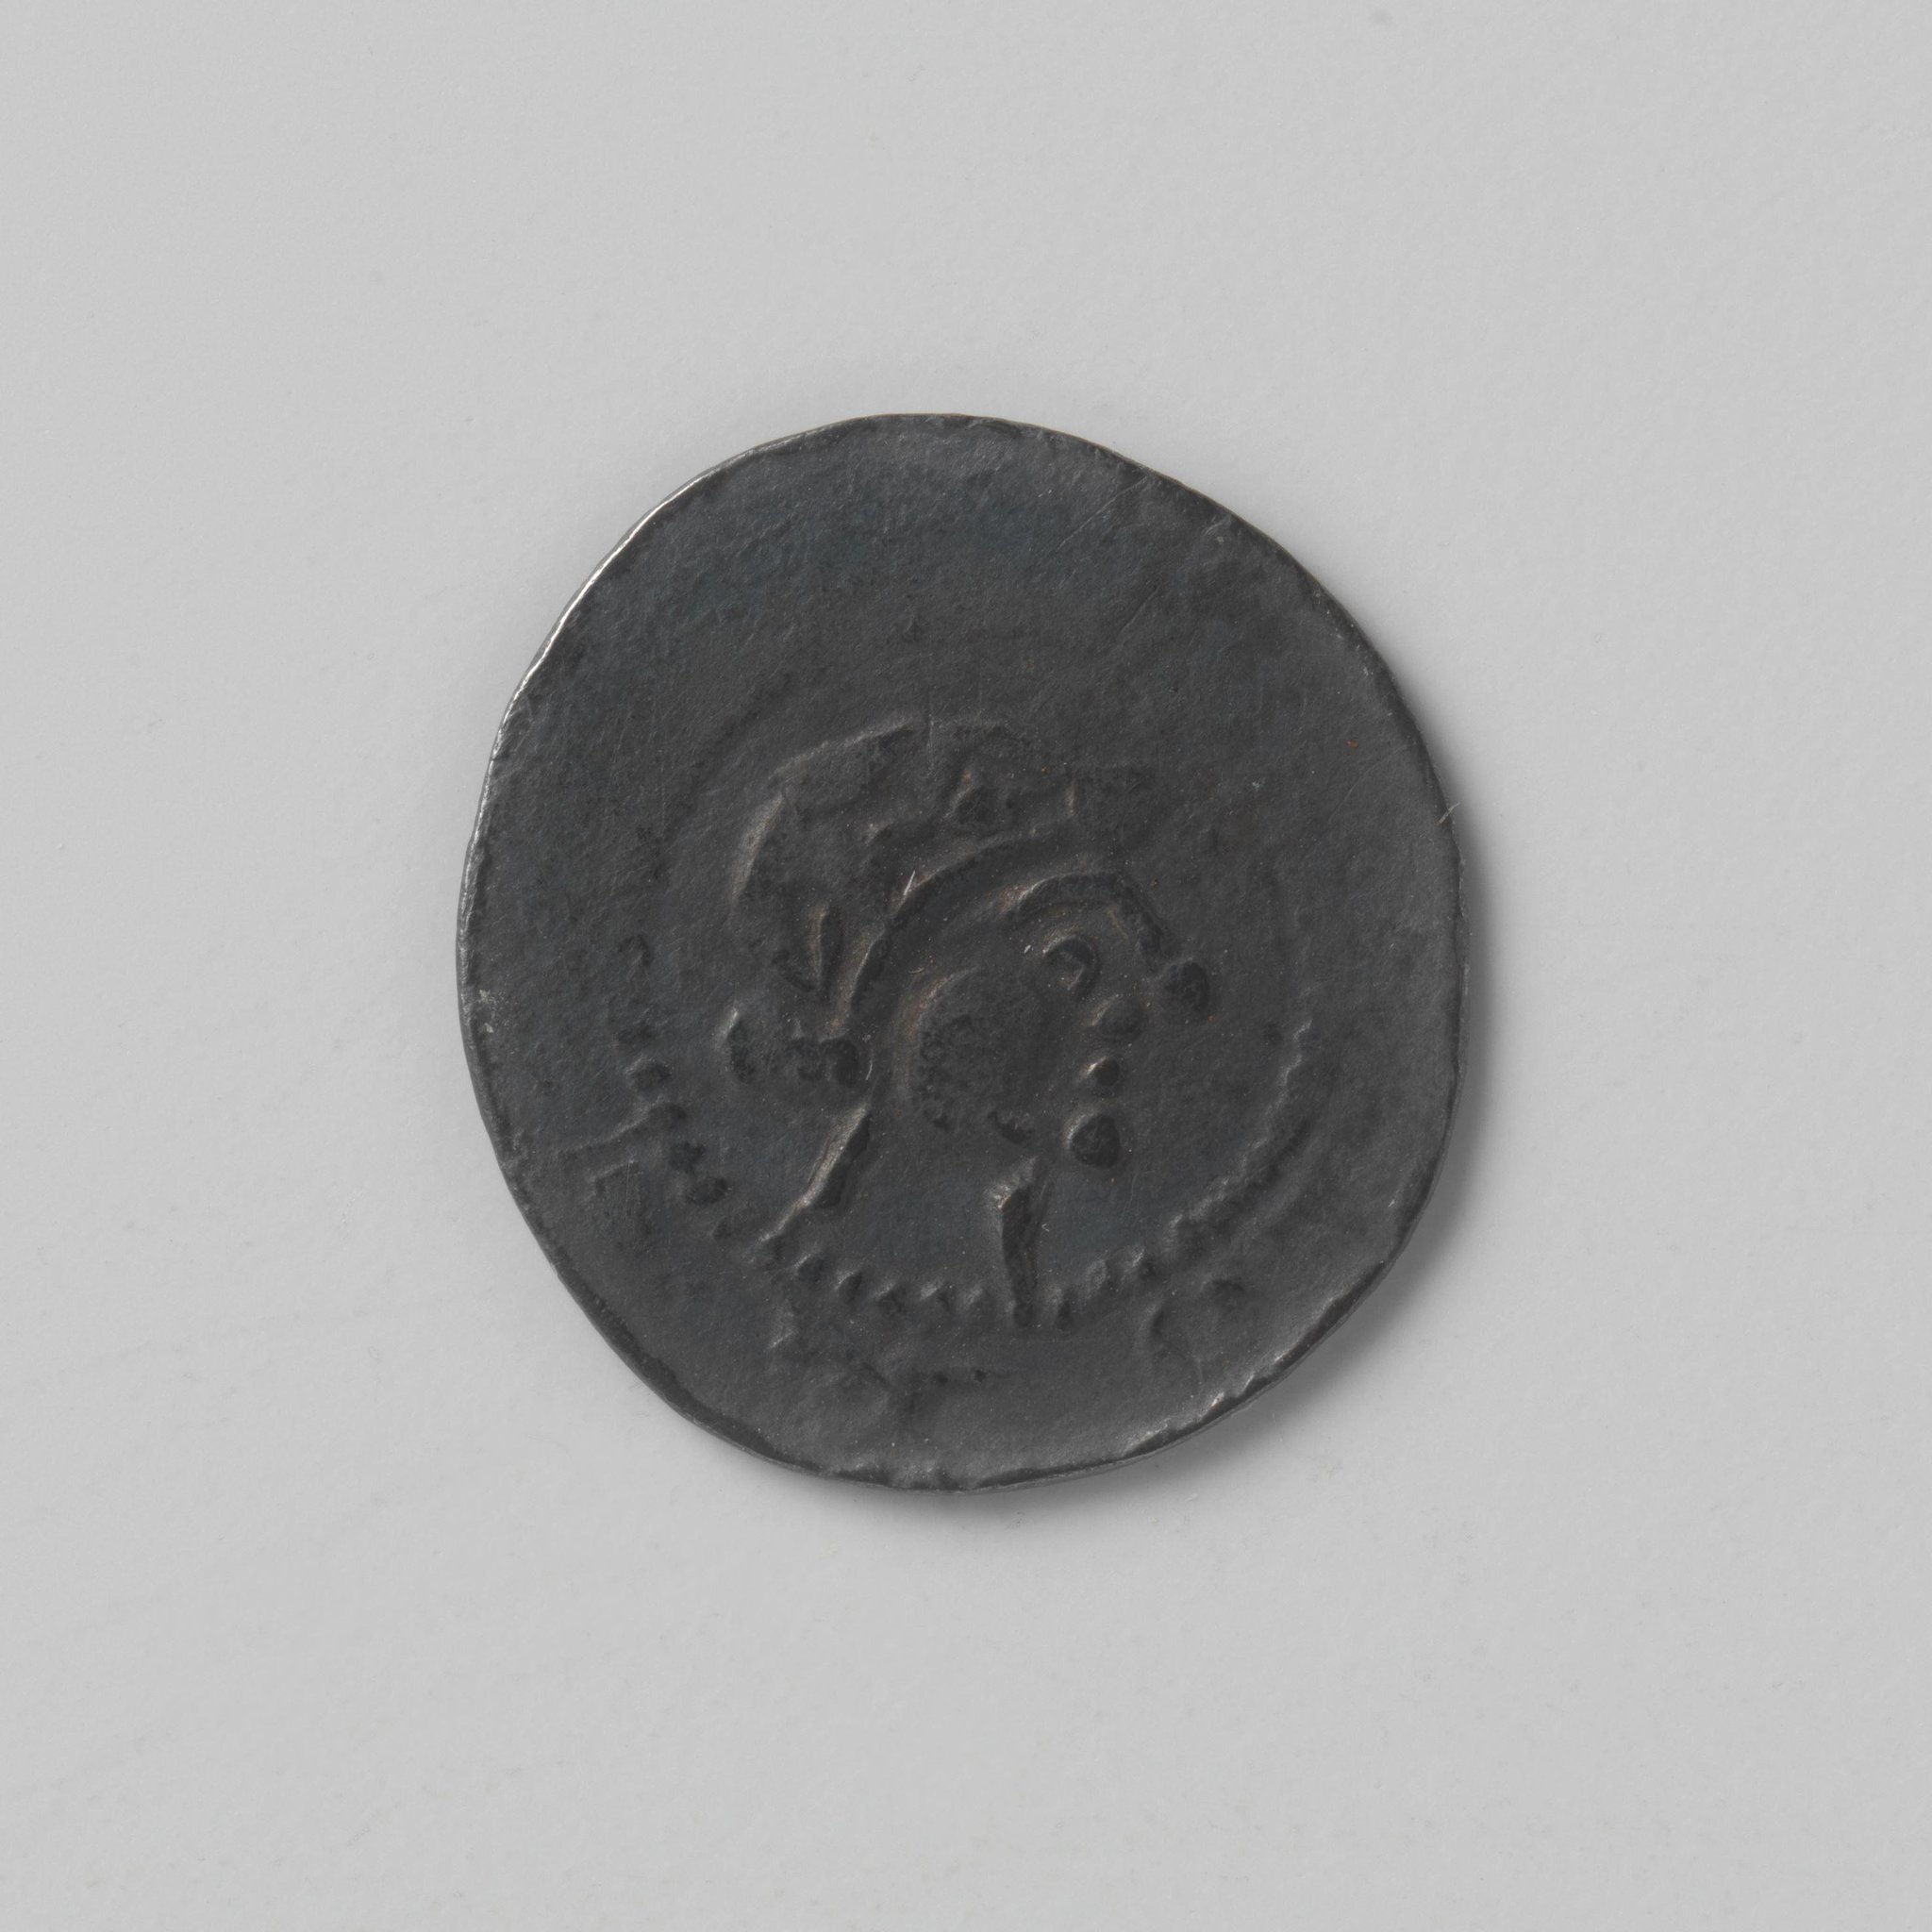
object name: penny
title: Holland, Floris V, penning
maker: floris v (graaf van holland en zeeland)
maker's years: 1254-1296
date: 1275-1284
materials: silver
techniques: striking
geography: dordrecht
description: Zilveren munt. Voorzijde: hoofd met gravenmuts naar rechts. Keerzijde: lang dubbellijnig kruis.